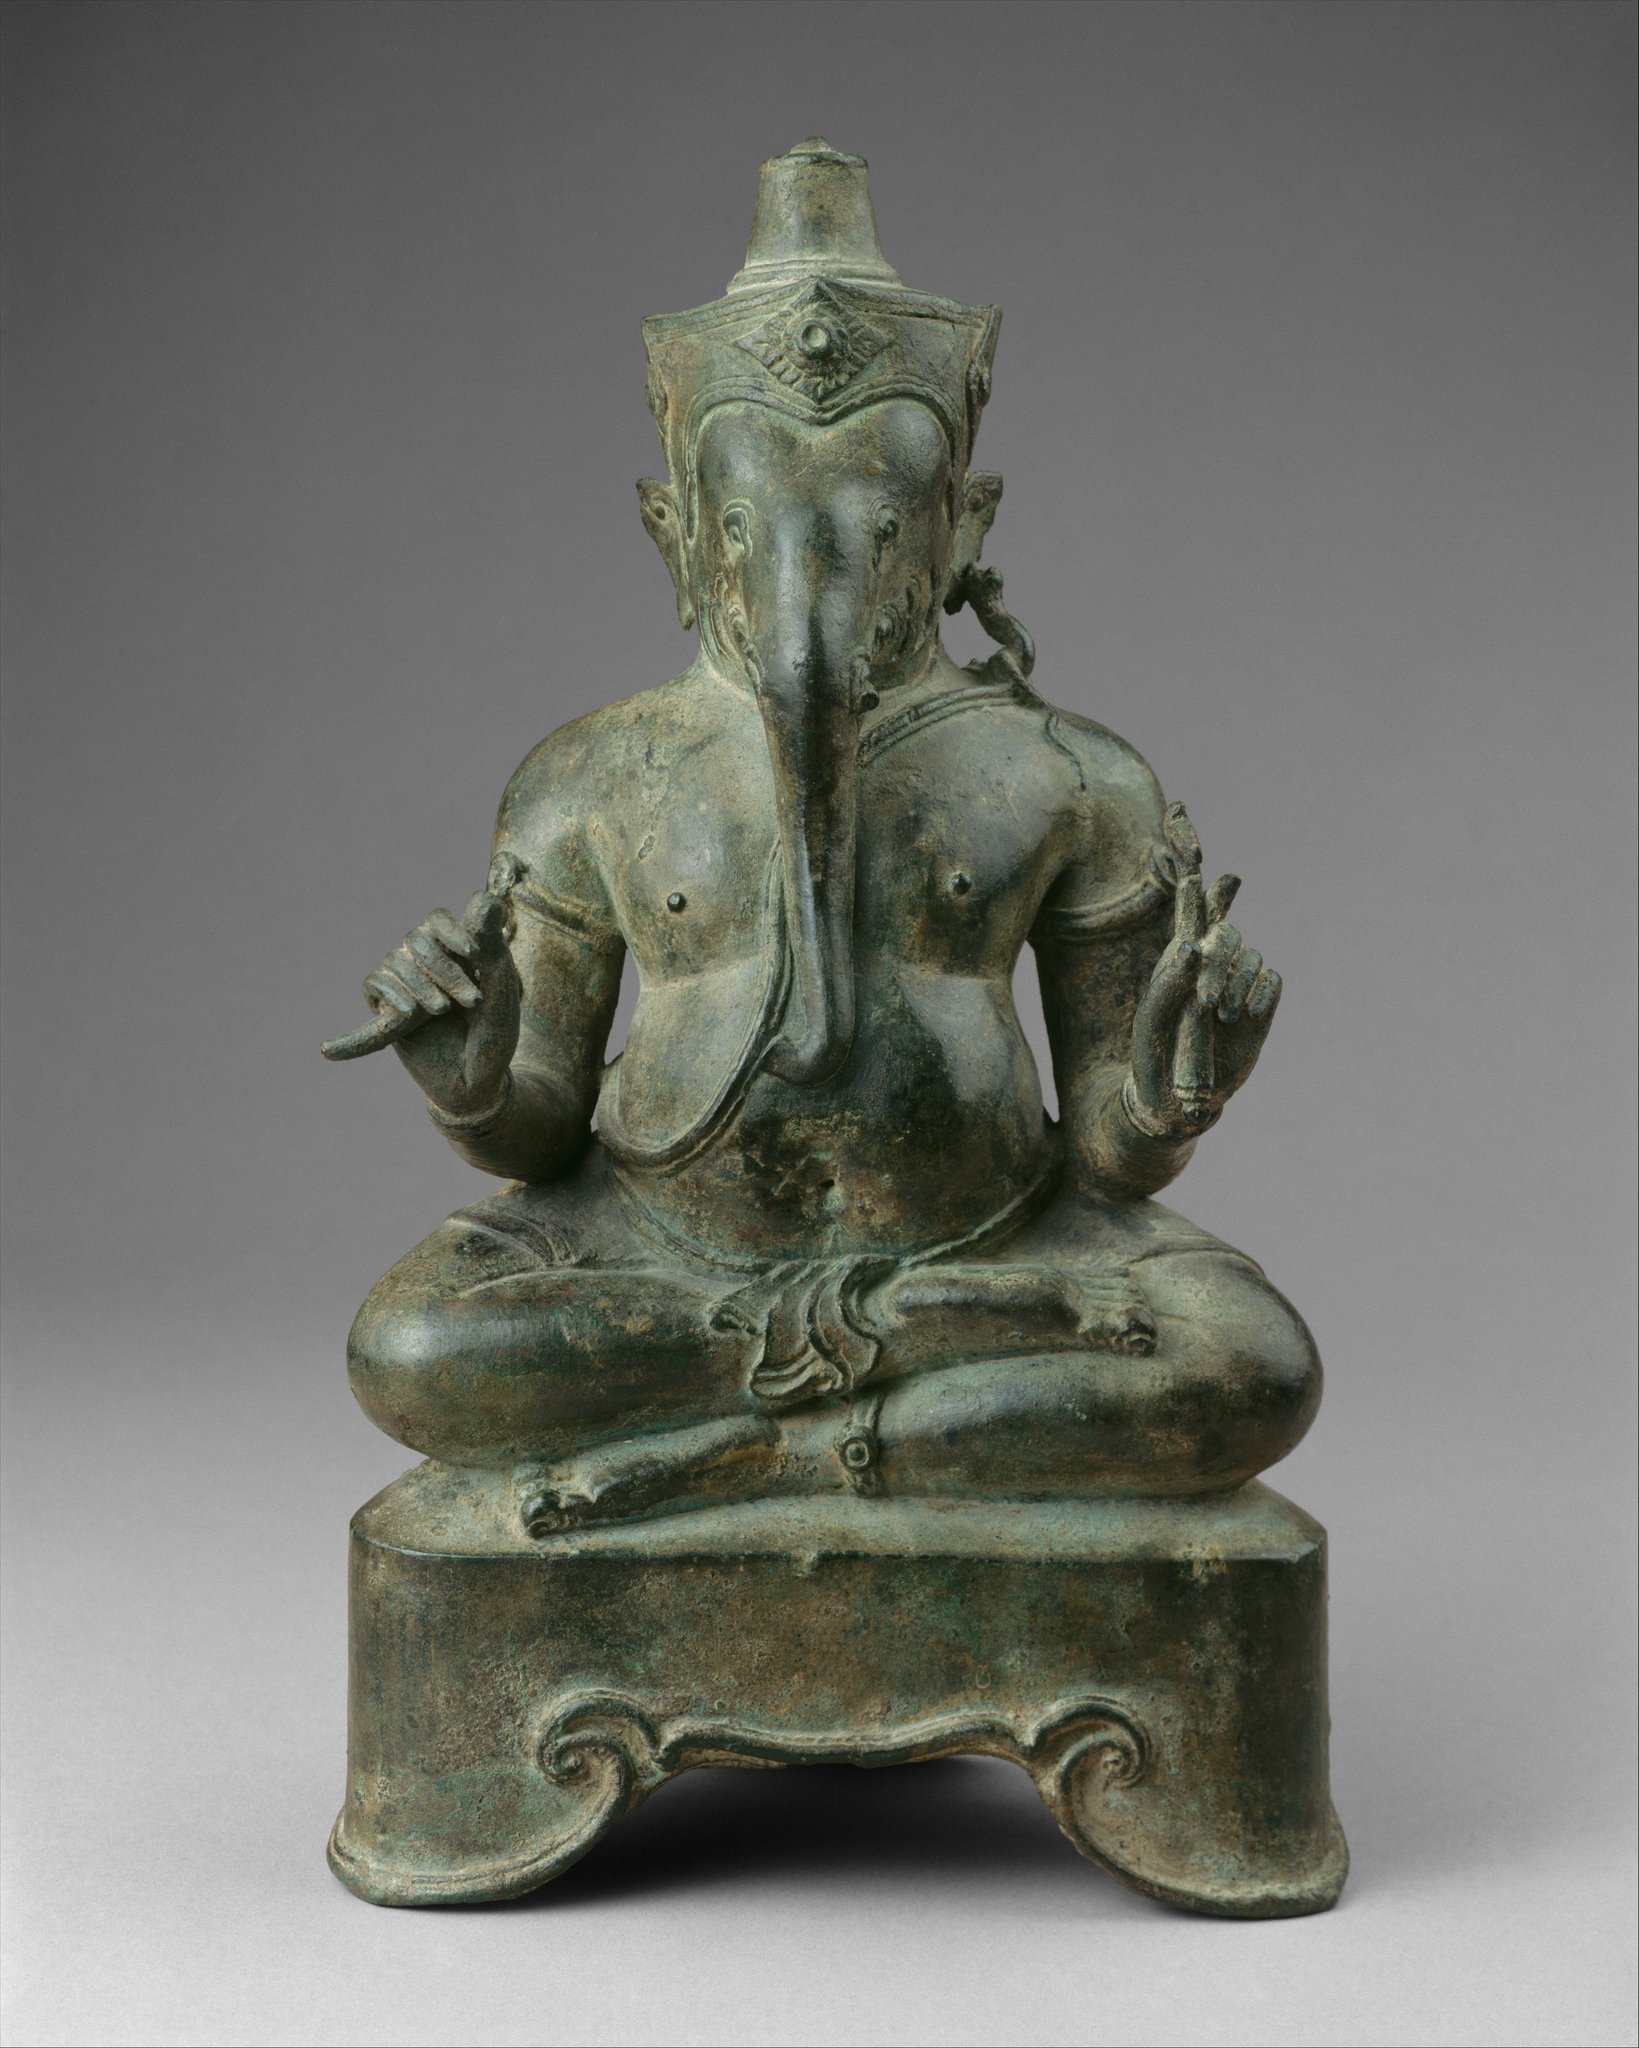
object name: figure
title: Seated Ganesha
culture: thai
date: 1401-1500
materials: bronze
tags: elephants,ganesha,hinduism